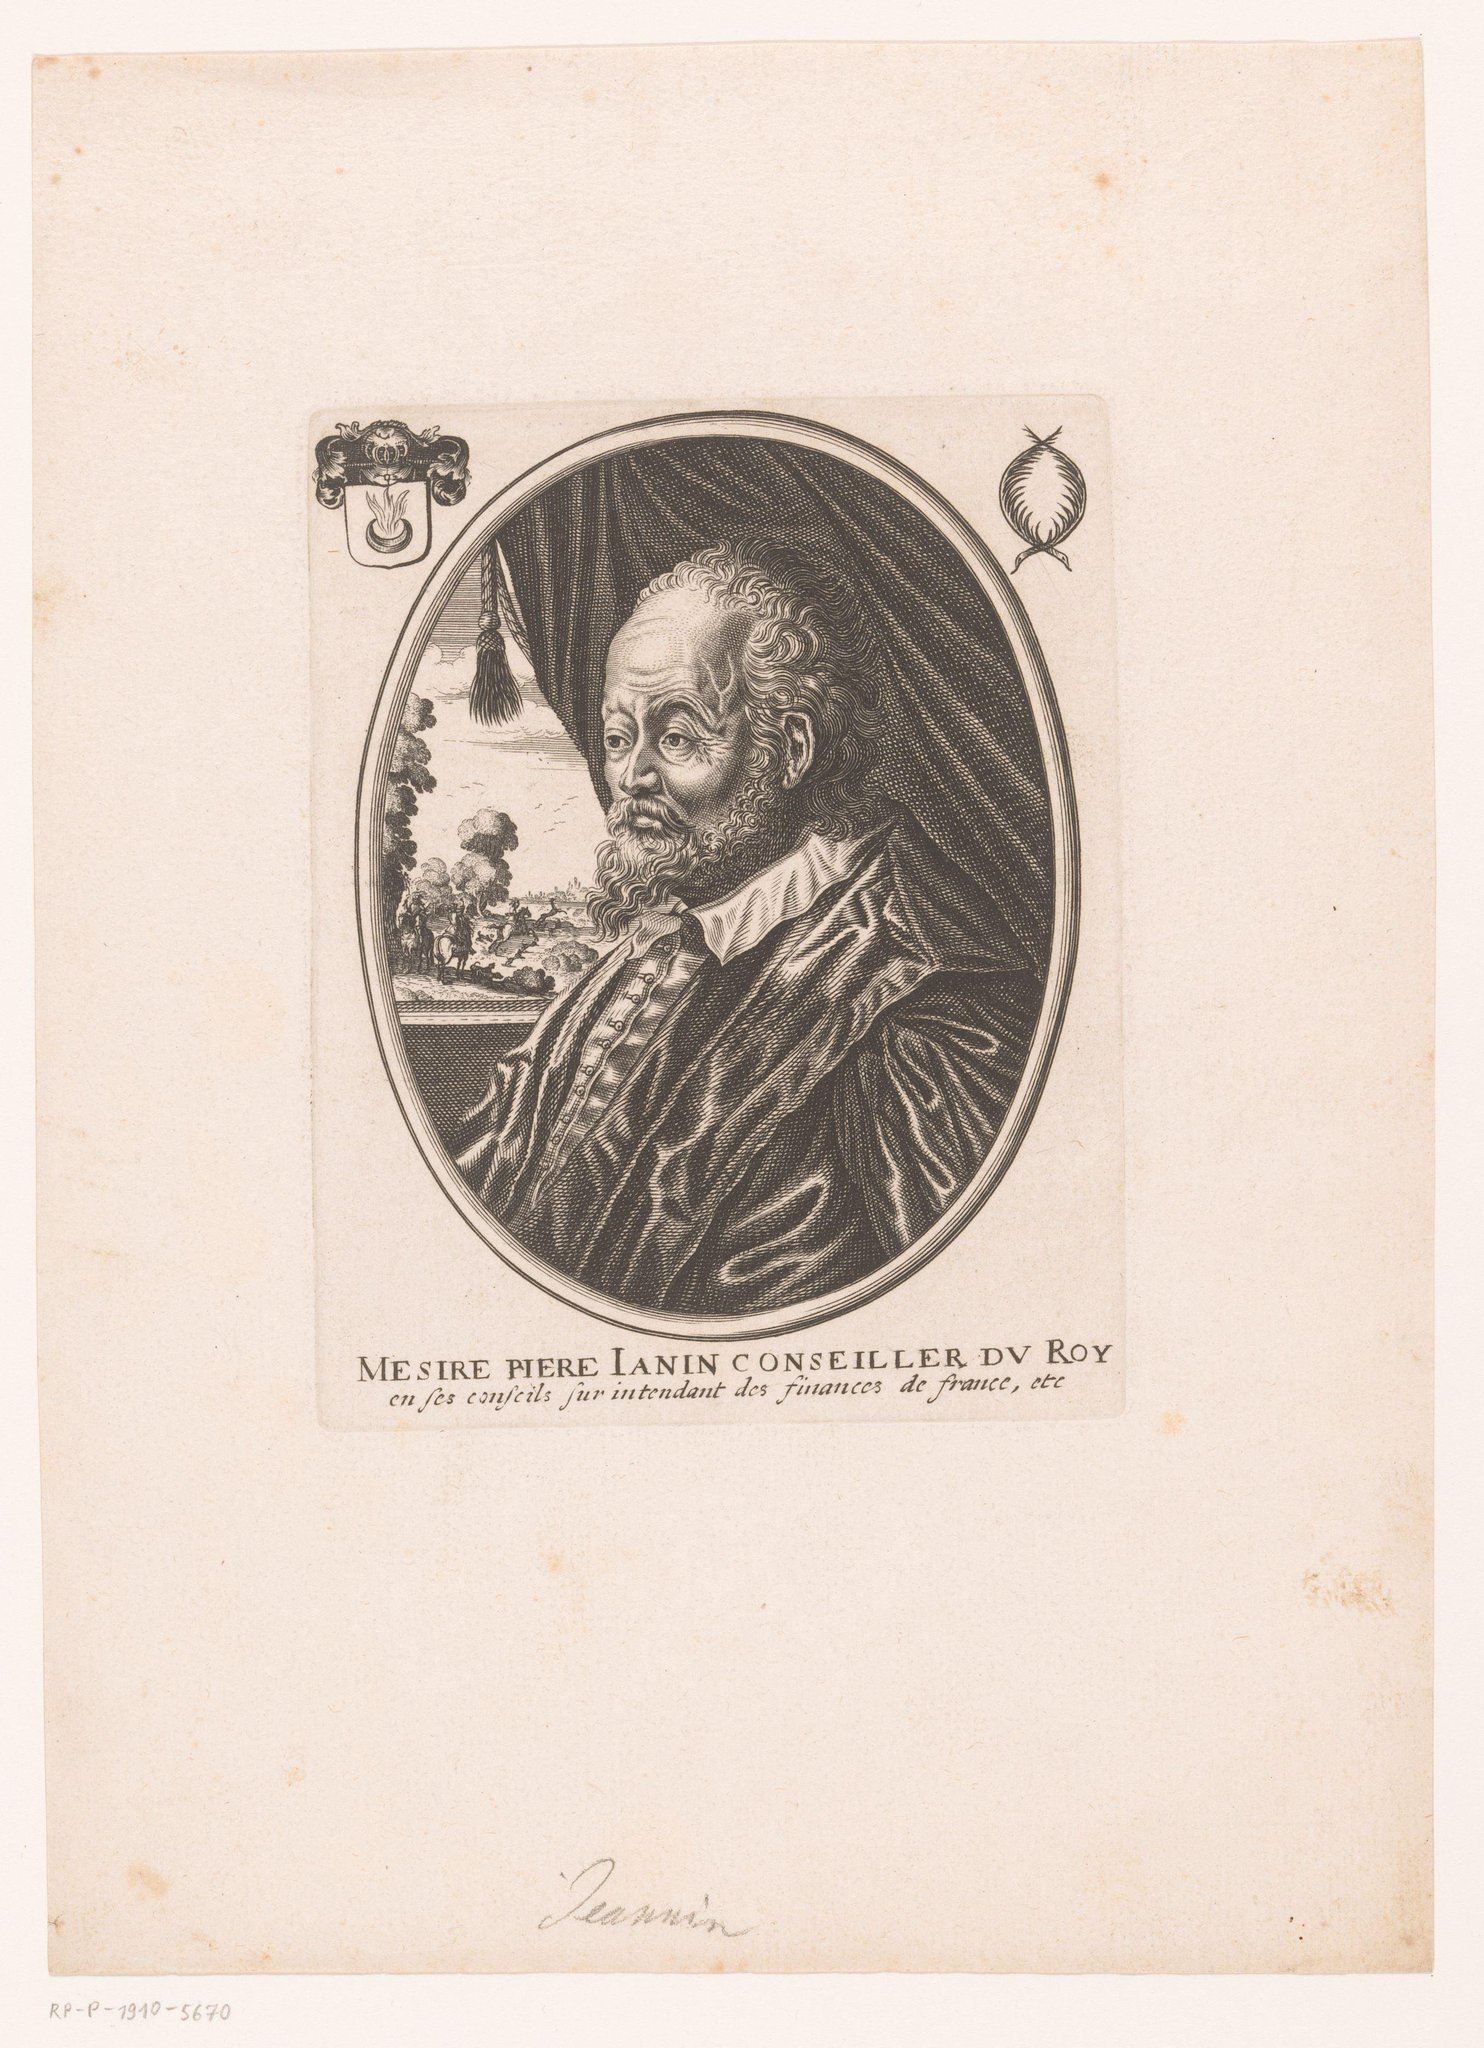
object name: print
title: Portret van Ibrahim I, sultan van het Ottomaanse Rijk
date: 1610-1668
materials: paper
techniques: engraving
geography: paris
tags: historical persons, armorial bearing, heraldry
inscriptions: collector's mark: Lugt 2228